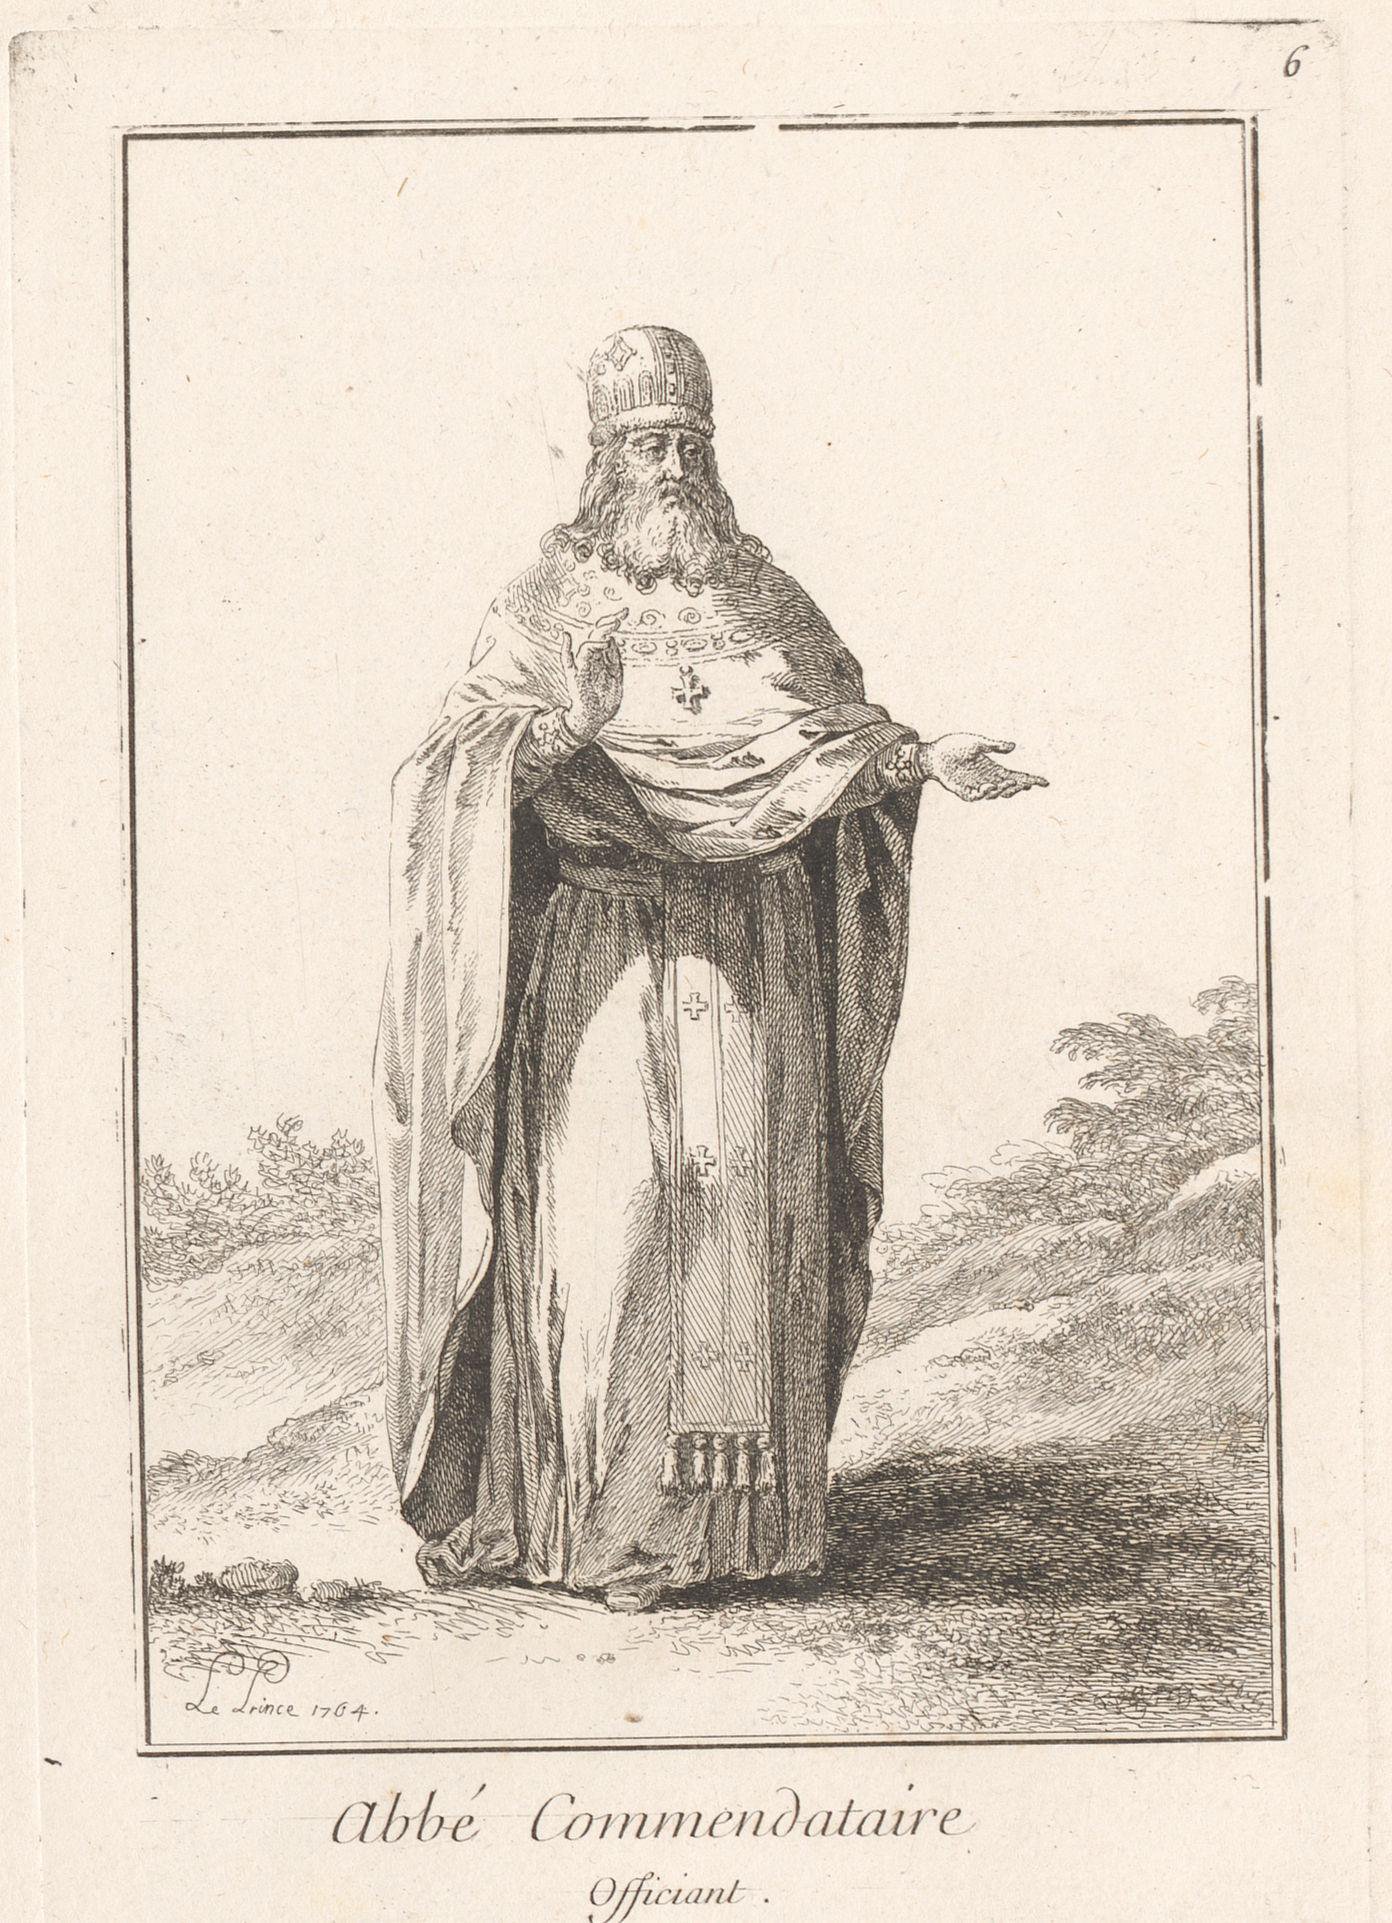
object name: print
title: Divers Habillements des Prêtres de Russie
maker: jean baptist leprince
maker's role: draughtsman, print maker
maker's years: 1734-1781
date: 1764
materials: paper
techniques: etching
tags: russian orthodox church, abbot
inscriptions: date